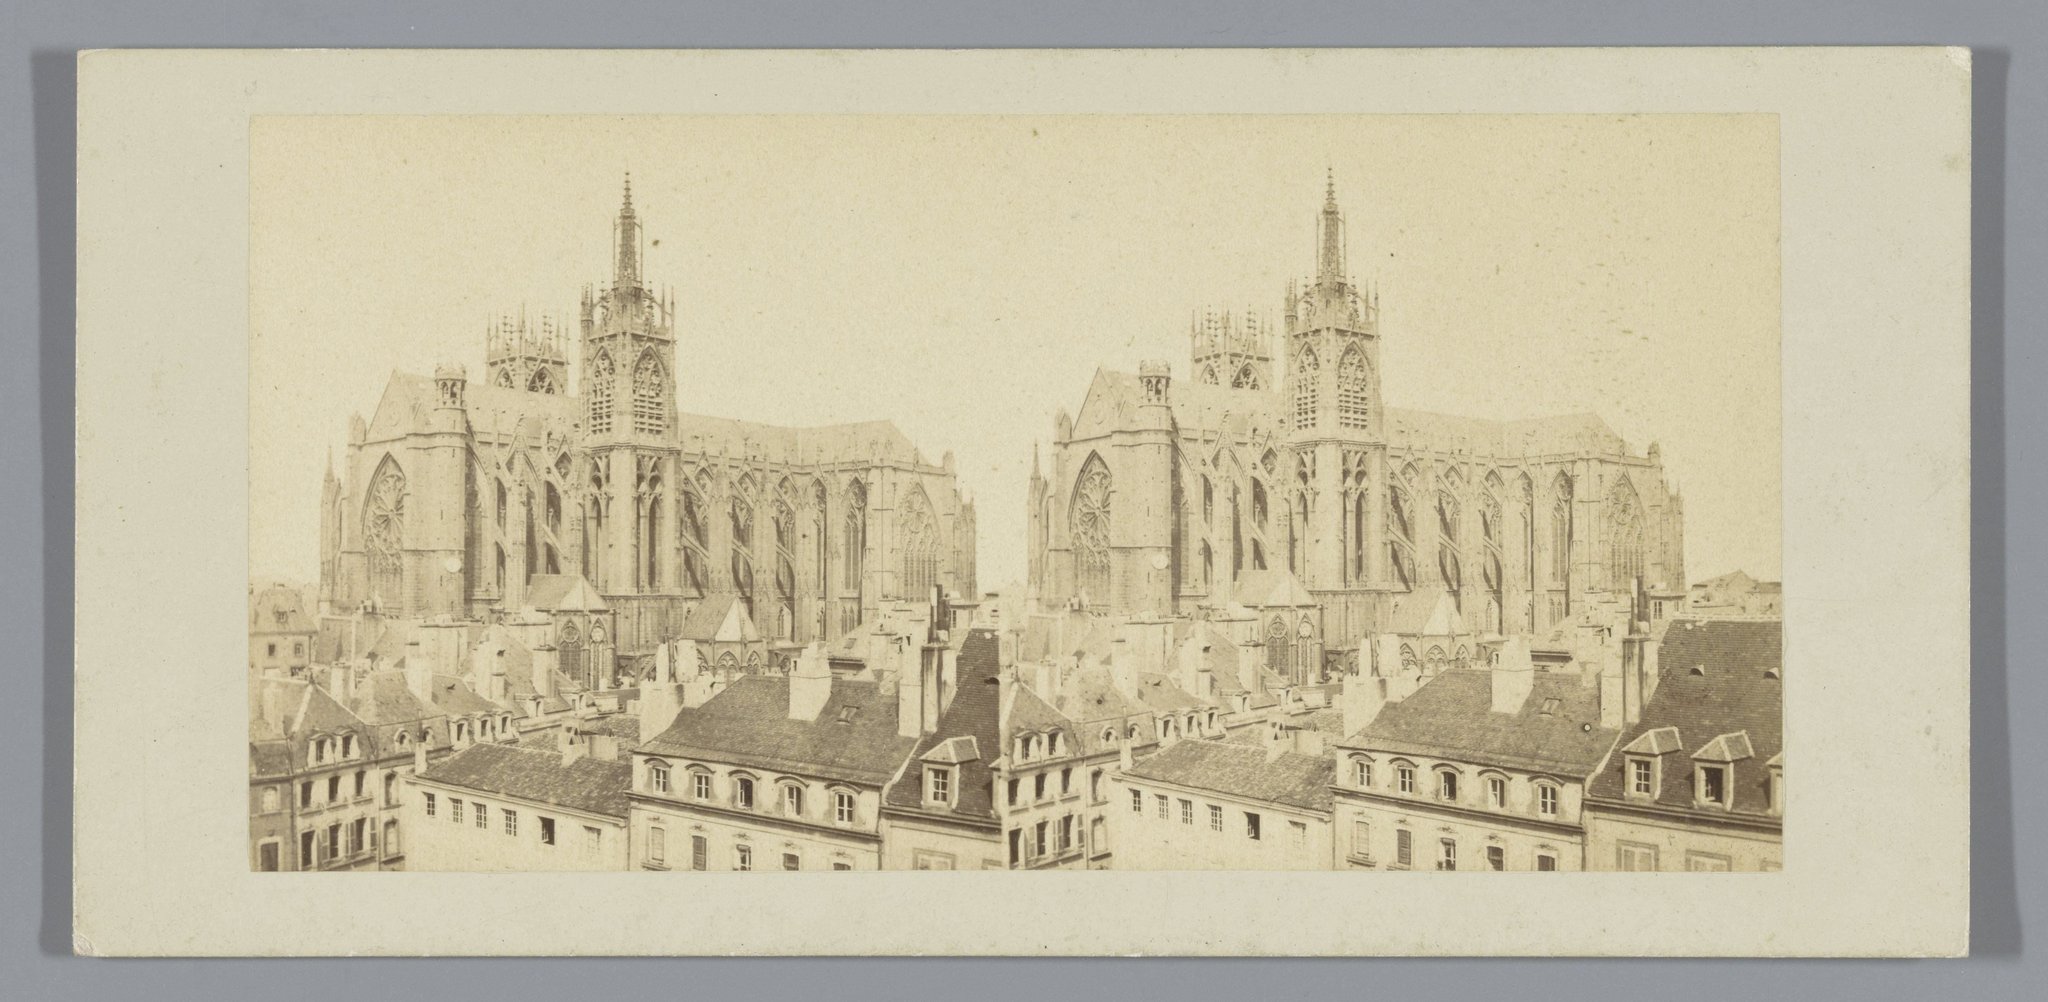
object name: stereograph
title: Gezicht op de kathedraal van Metz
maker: Anonymous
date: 1860-1875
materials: cardboard, photographic support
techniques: albumen print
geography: metz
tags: church (exterior)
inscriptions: inscription: ‘Metz’